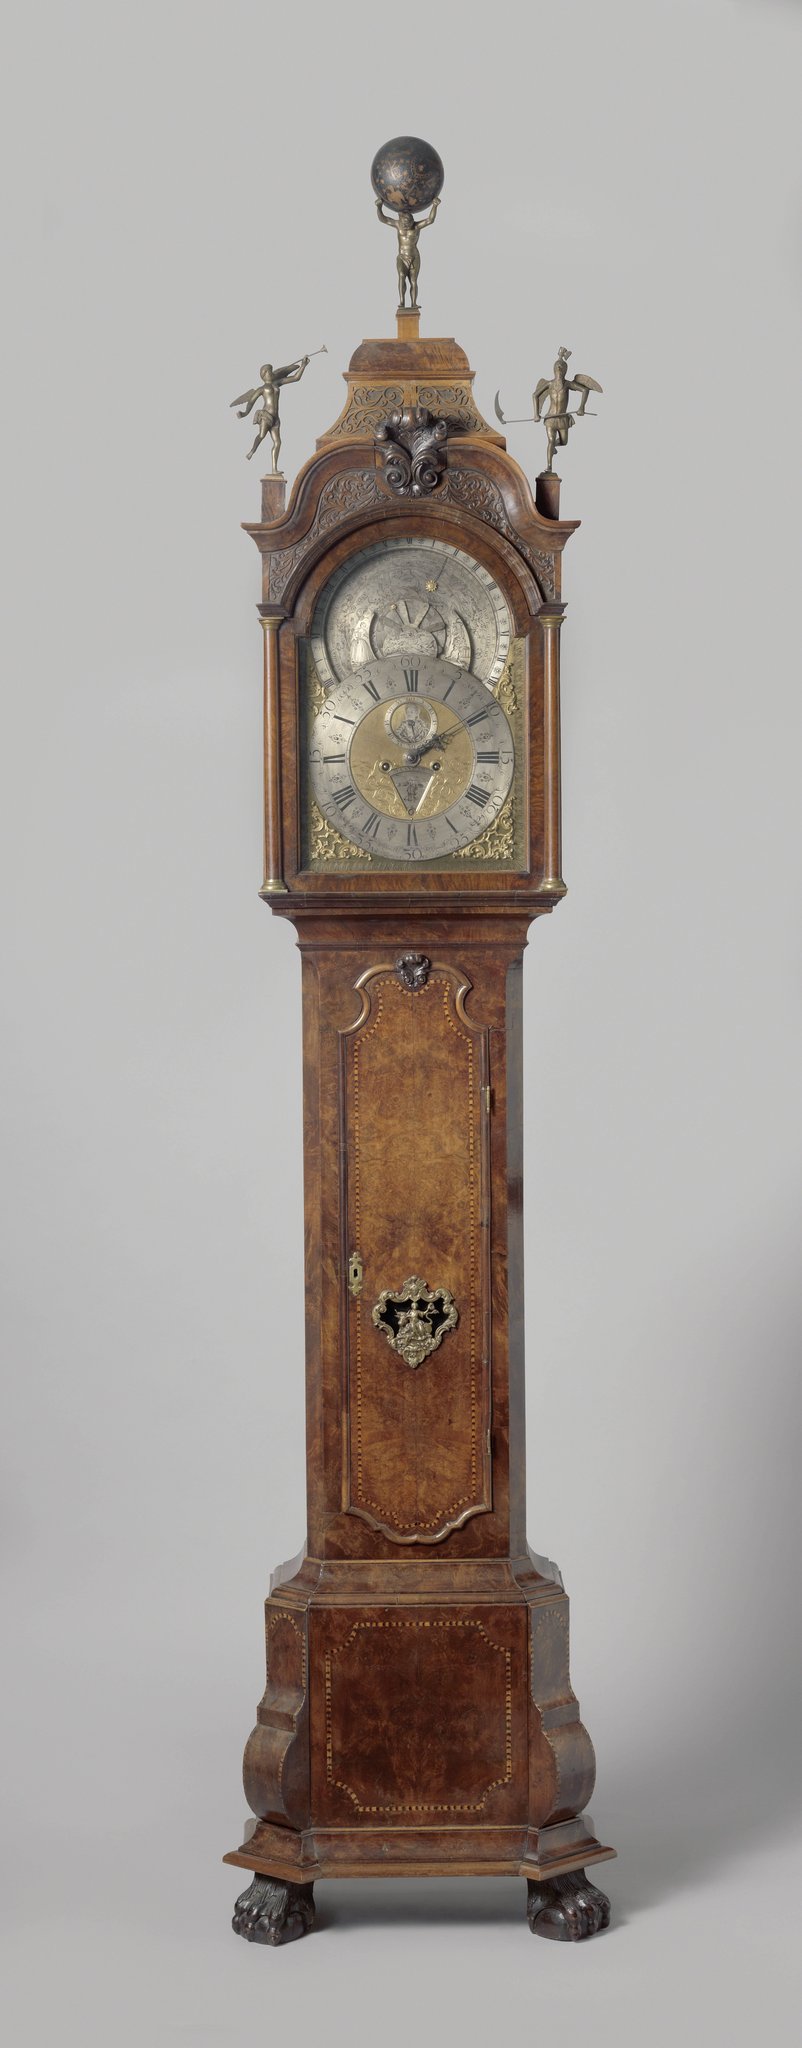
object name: mechanical clock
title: Longcase clock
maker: anthonie van oostrom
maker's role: clockmaker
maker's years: -1768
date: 1700-1750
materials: brass, bronze, glass, wood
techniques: gilding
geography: amsterdam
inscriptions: signature: ‘A van Oostrom Amsterdam’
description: Staande klok van notenhout. Het voetstuk op klauwpoten heeft schuin geplaatste consolevormige hoekstijlen. De hoekstijlen en het middenveld tonen een sierrand in marqueterie, evenals de onder en boven geschulpte kastdeur met kuifstuk en verguld koperen beslagstuk. De gewelfde kap heeft een opengewerkt fries op Toscaanse zuilen met koper, een kuifstuk en ter bekroning drie bronzen figuren van de Faam, de Tijd en Atlas op voetstukken. Van de twee wijzerplaten heeft de onderste een derde, met geëtst mansportret.